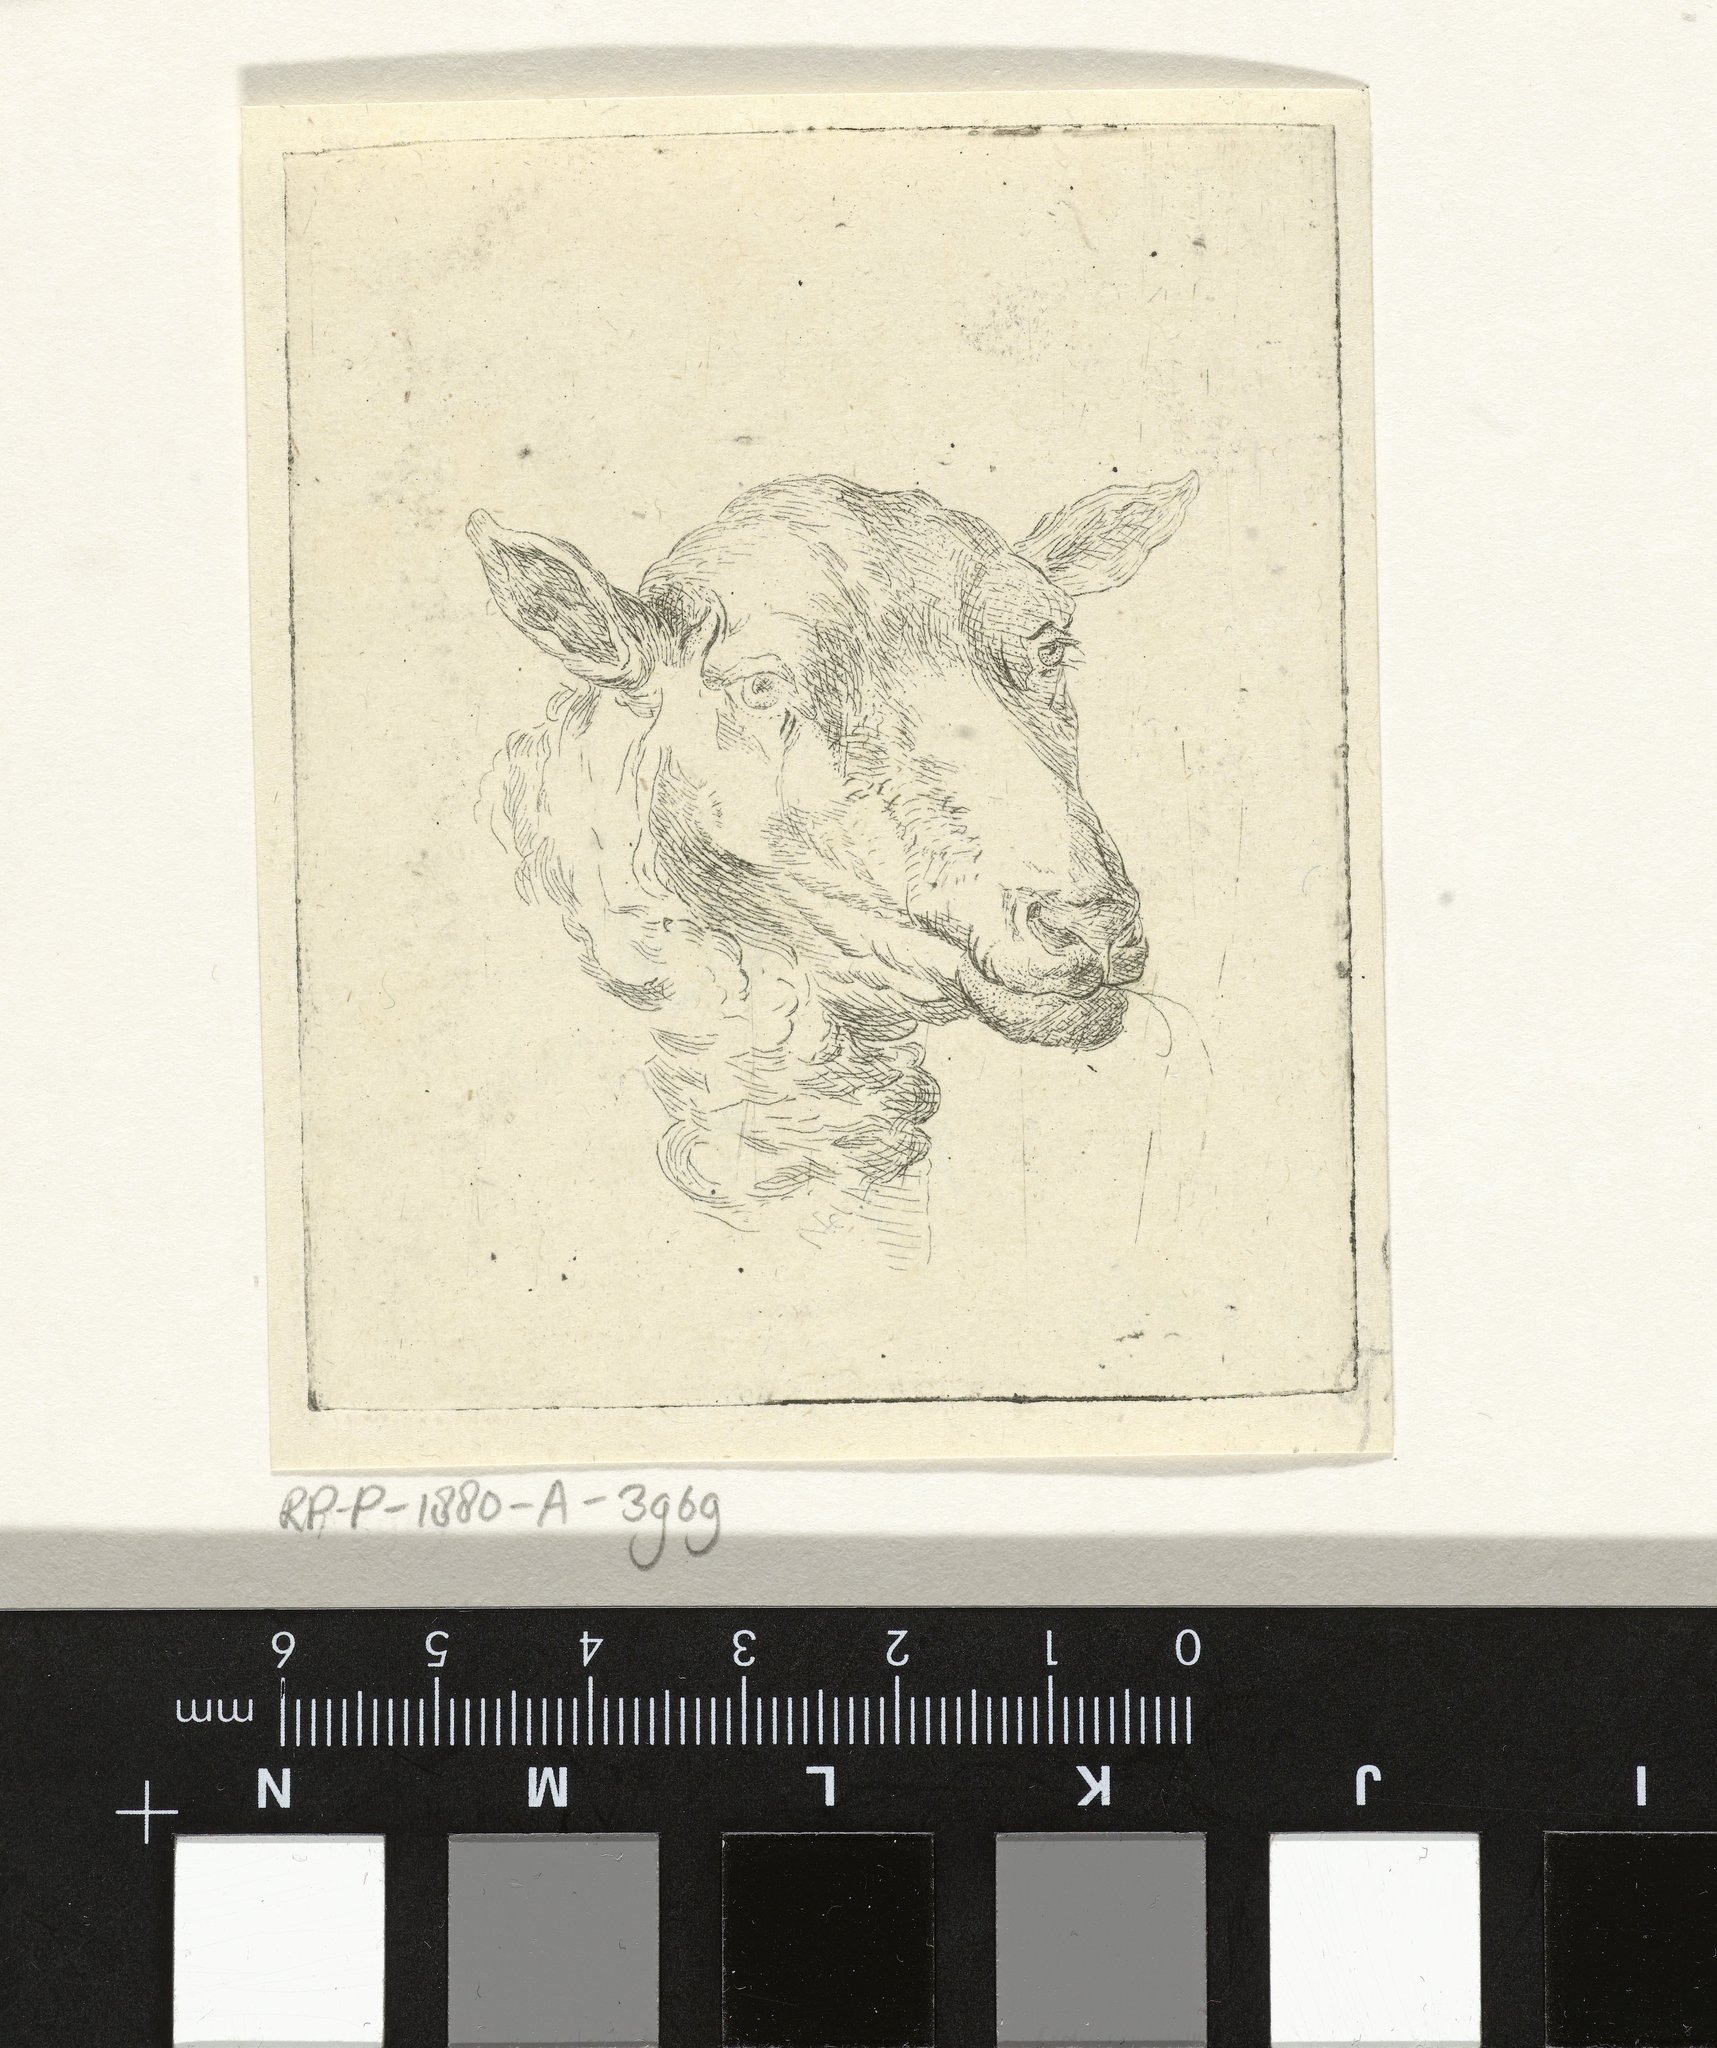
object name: print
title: Kop van een schaap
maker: reinierus albertus ludovicus baron van isendoorn à blois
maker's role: print maker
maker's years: 1786-1856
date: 1796-1856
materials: paper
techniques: etching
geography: vaassen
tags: sheep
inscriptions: collector's mark: Lugt 2228